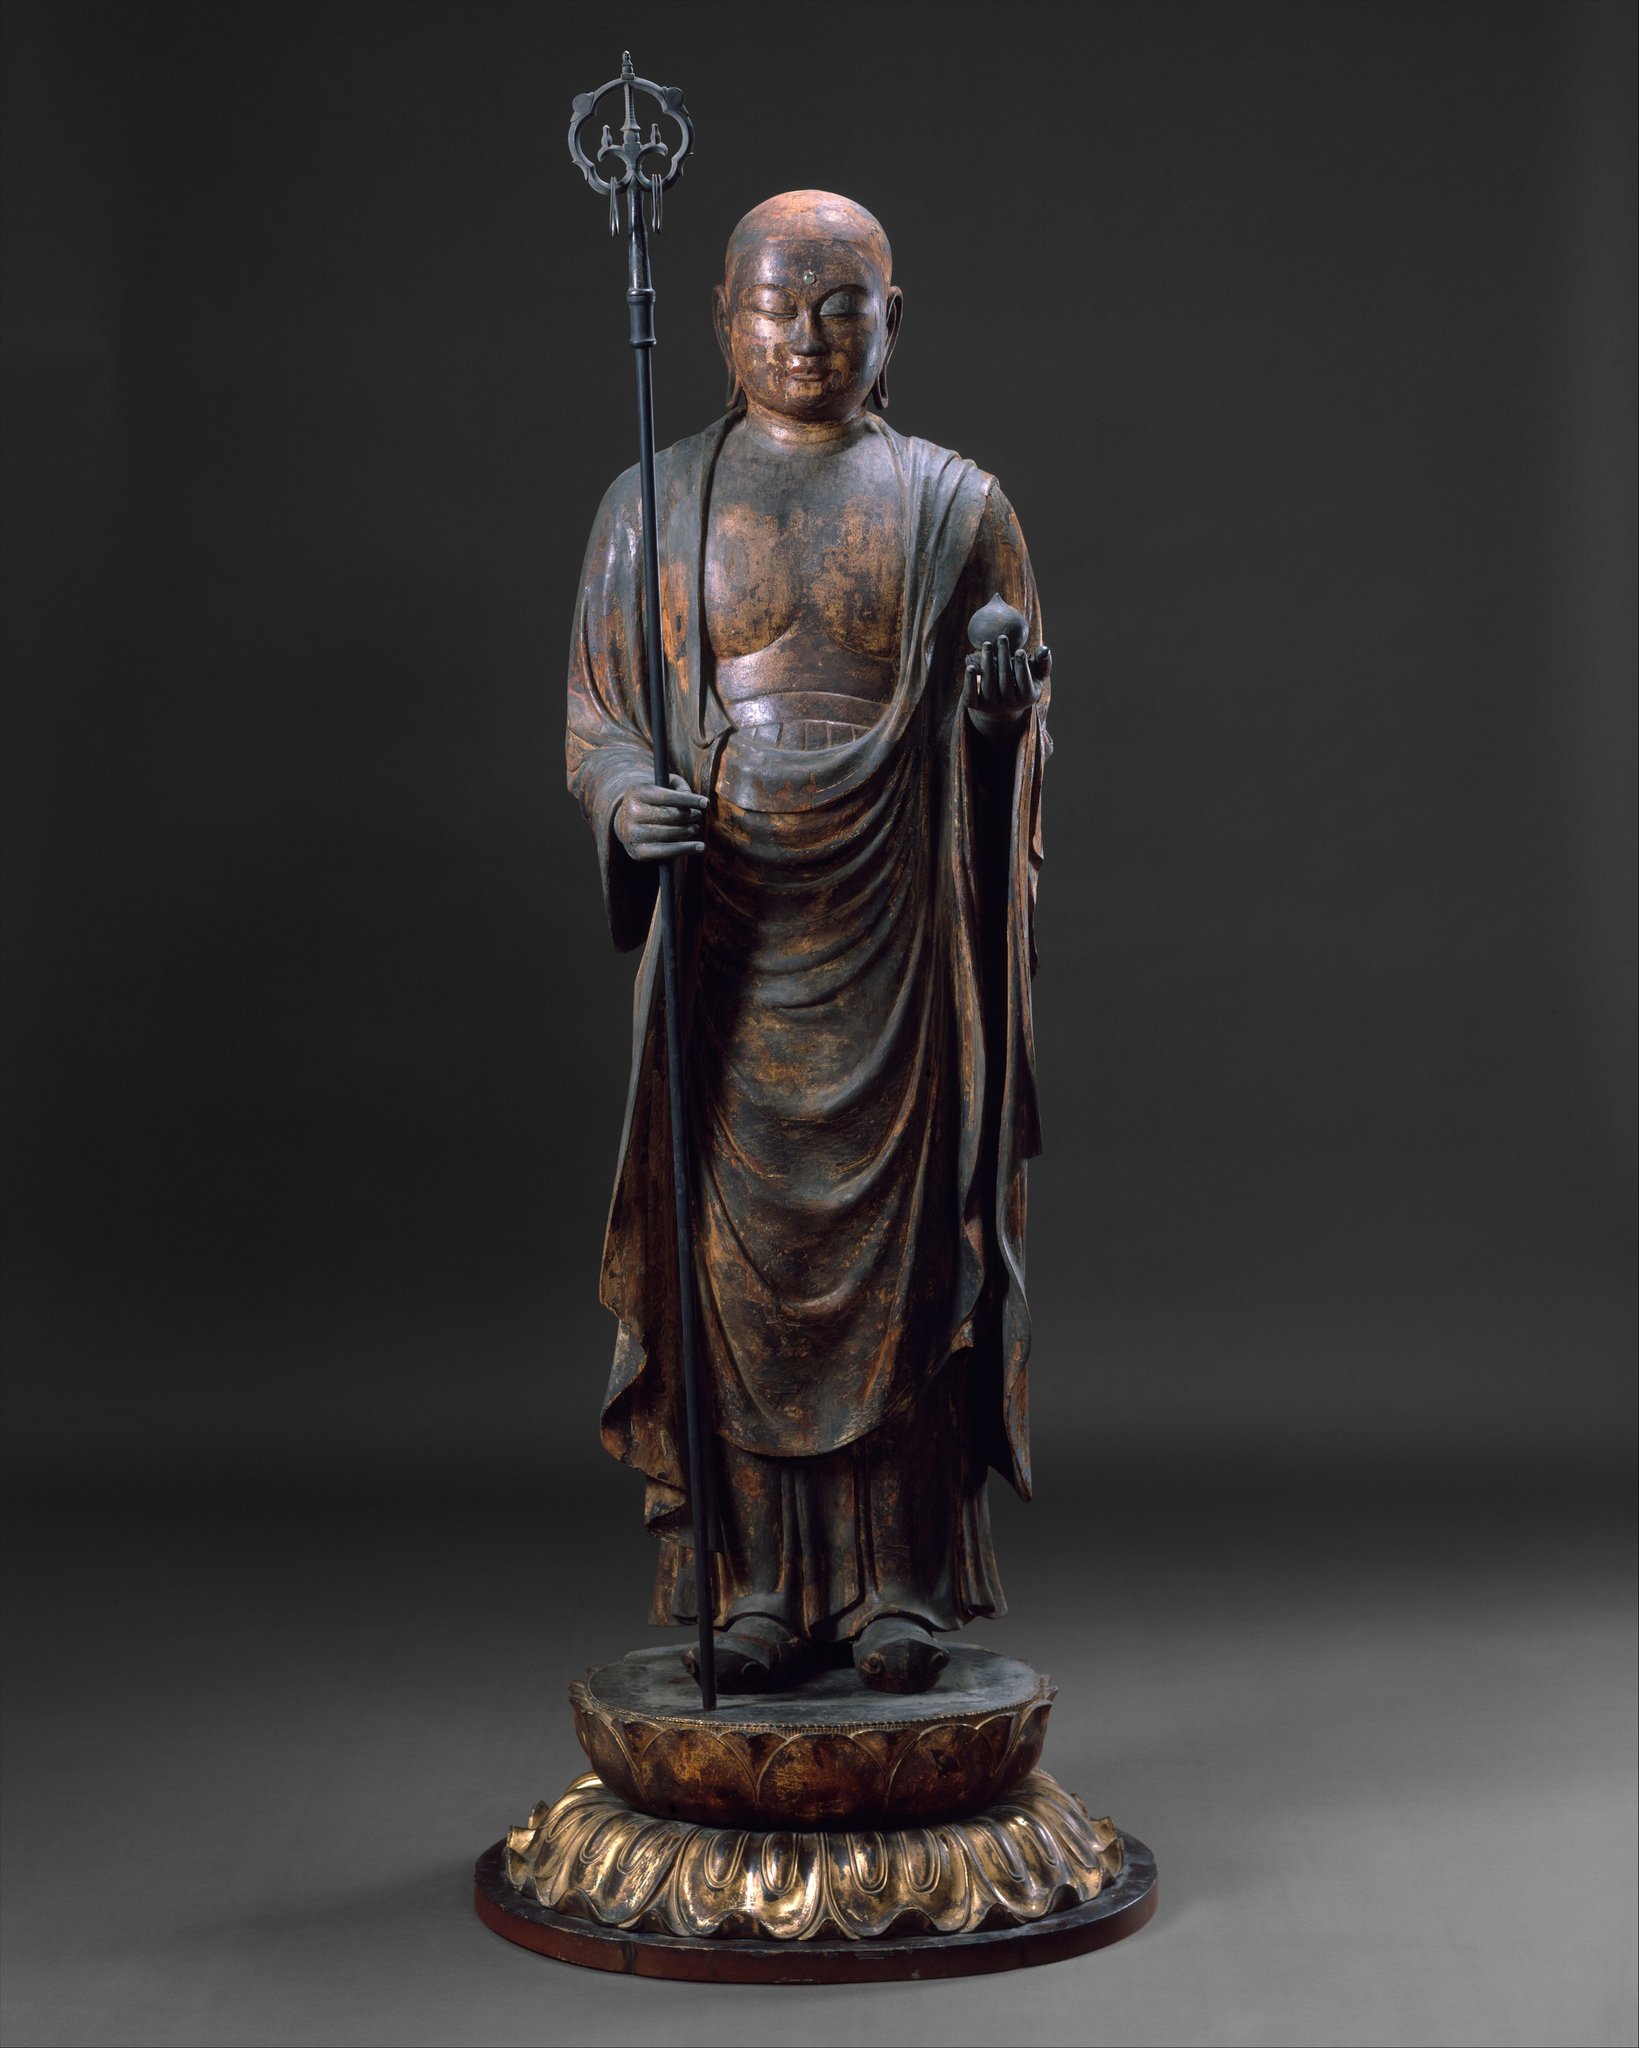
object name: figure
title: Jizō, the Bodhisattva of the Earth Store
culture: japanese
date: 1167-1266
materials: gold leaf, lacquer, wood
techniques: cutting, kirikane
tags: buddhism,bodhisattvas,monks